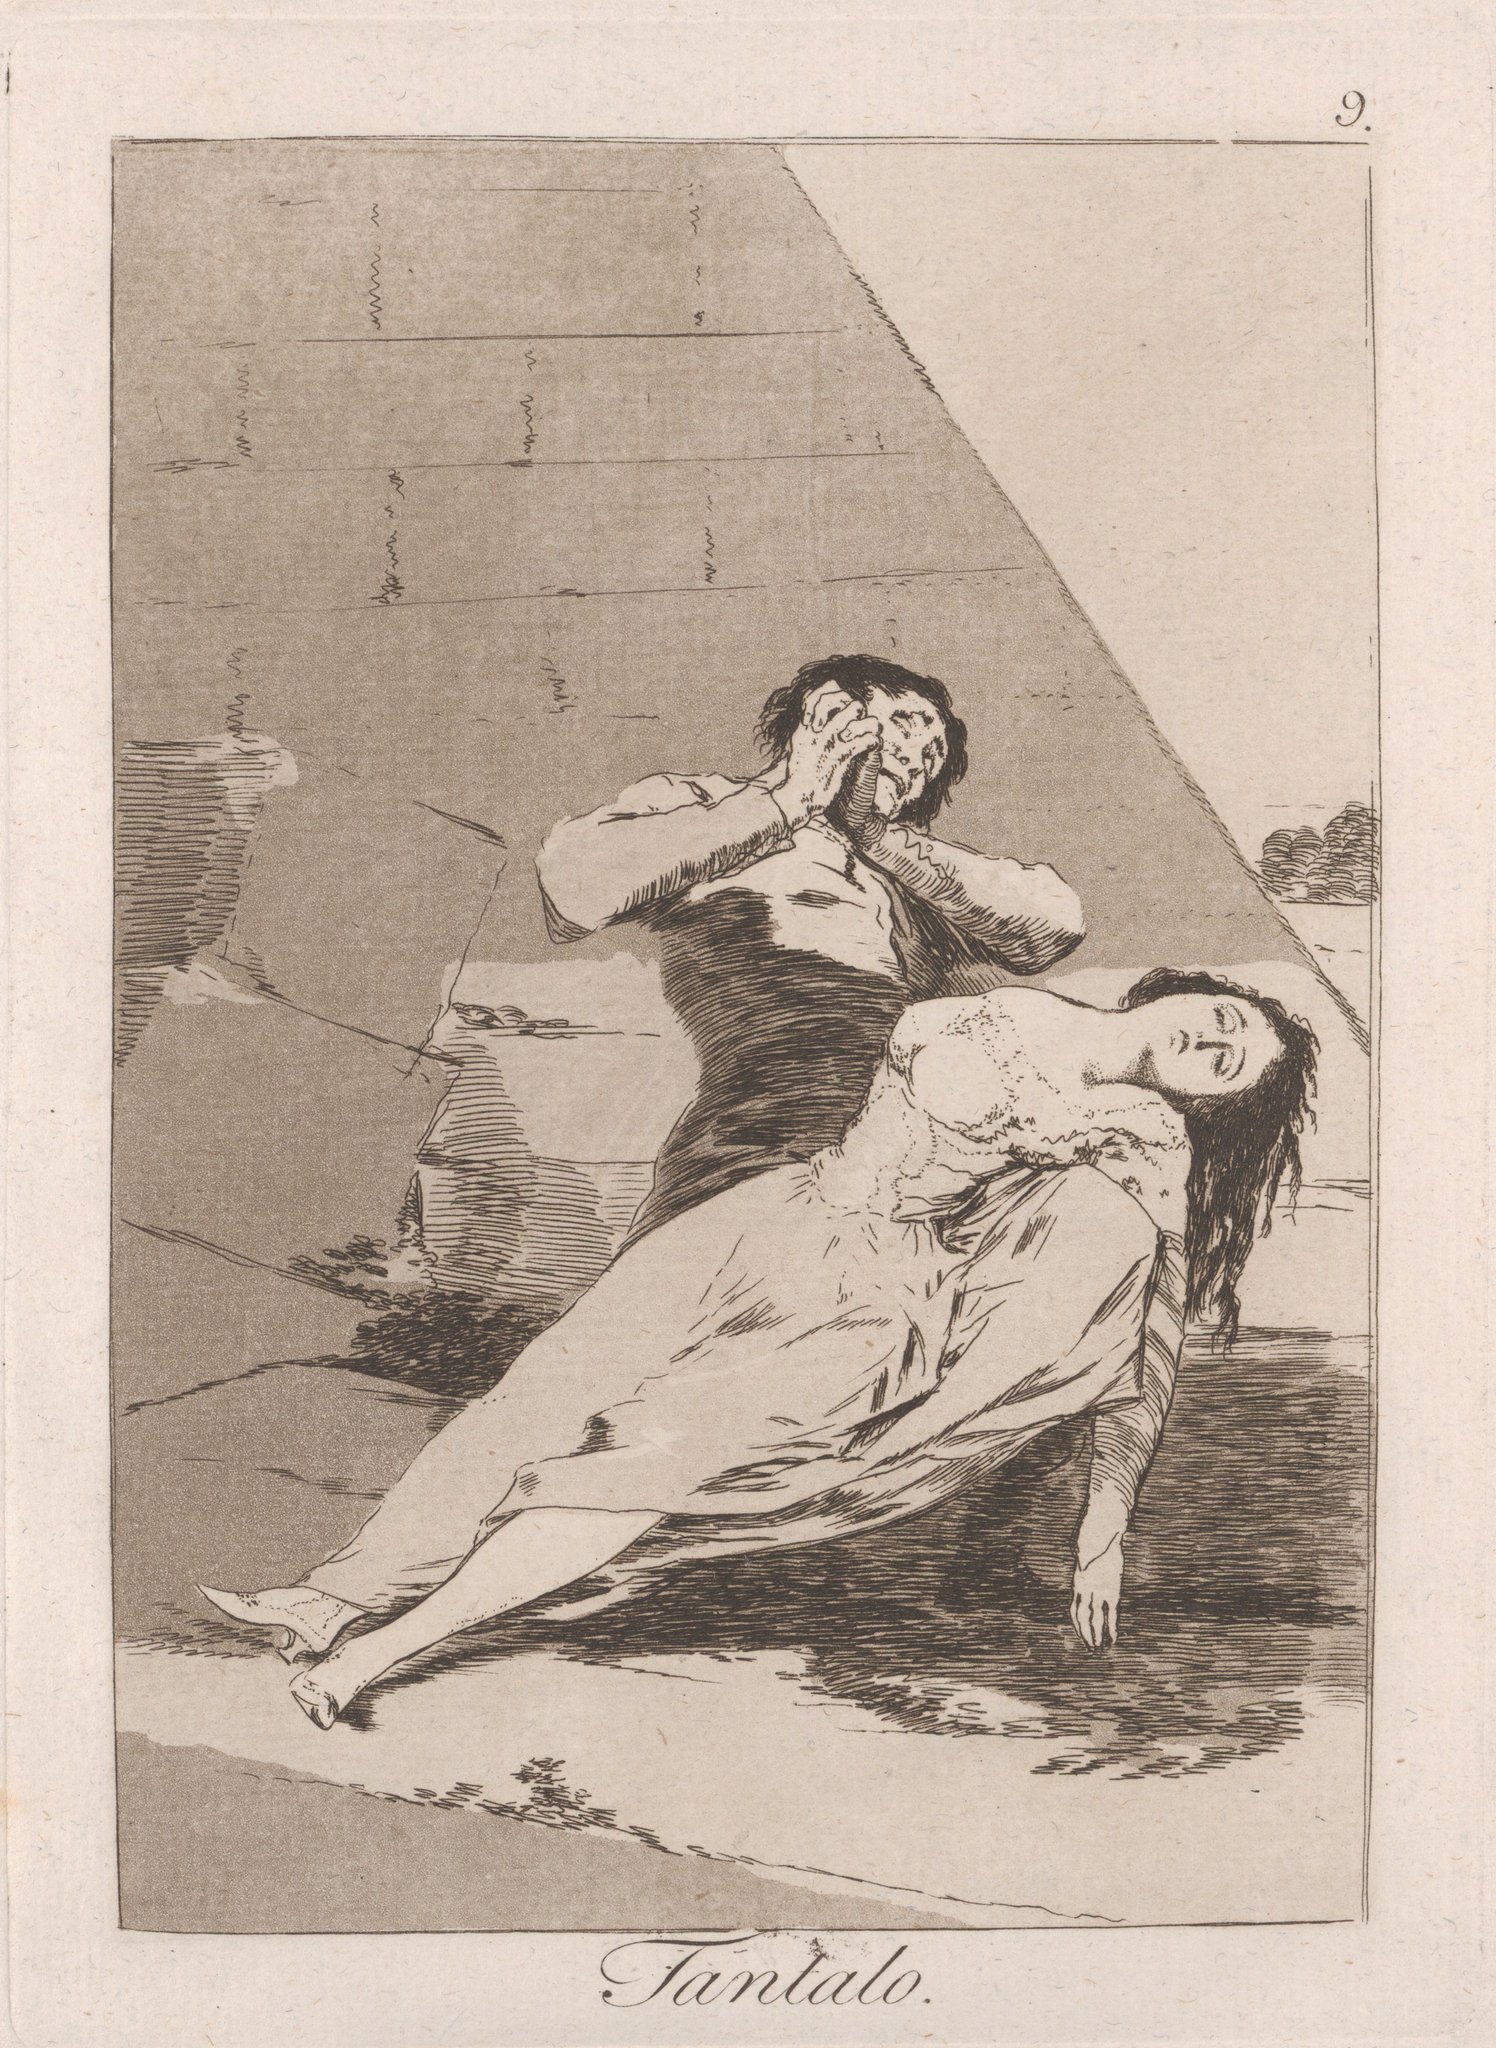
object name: print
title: Plate 9 from "Los Caprichos": Tantalus (Tantalo)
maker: goya (francisco de goya y lucientes)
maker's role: artist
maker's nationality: spanish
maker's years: 1746-1828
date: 1799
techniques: aquatint, burnishing, etching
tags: men,women